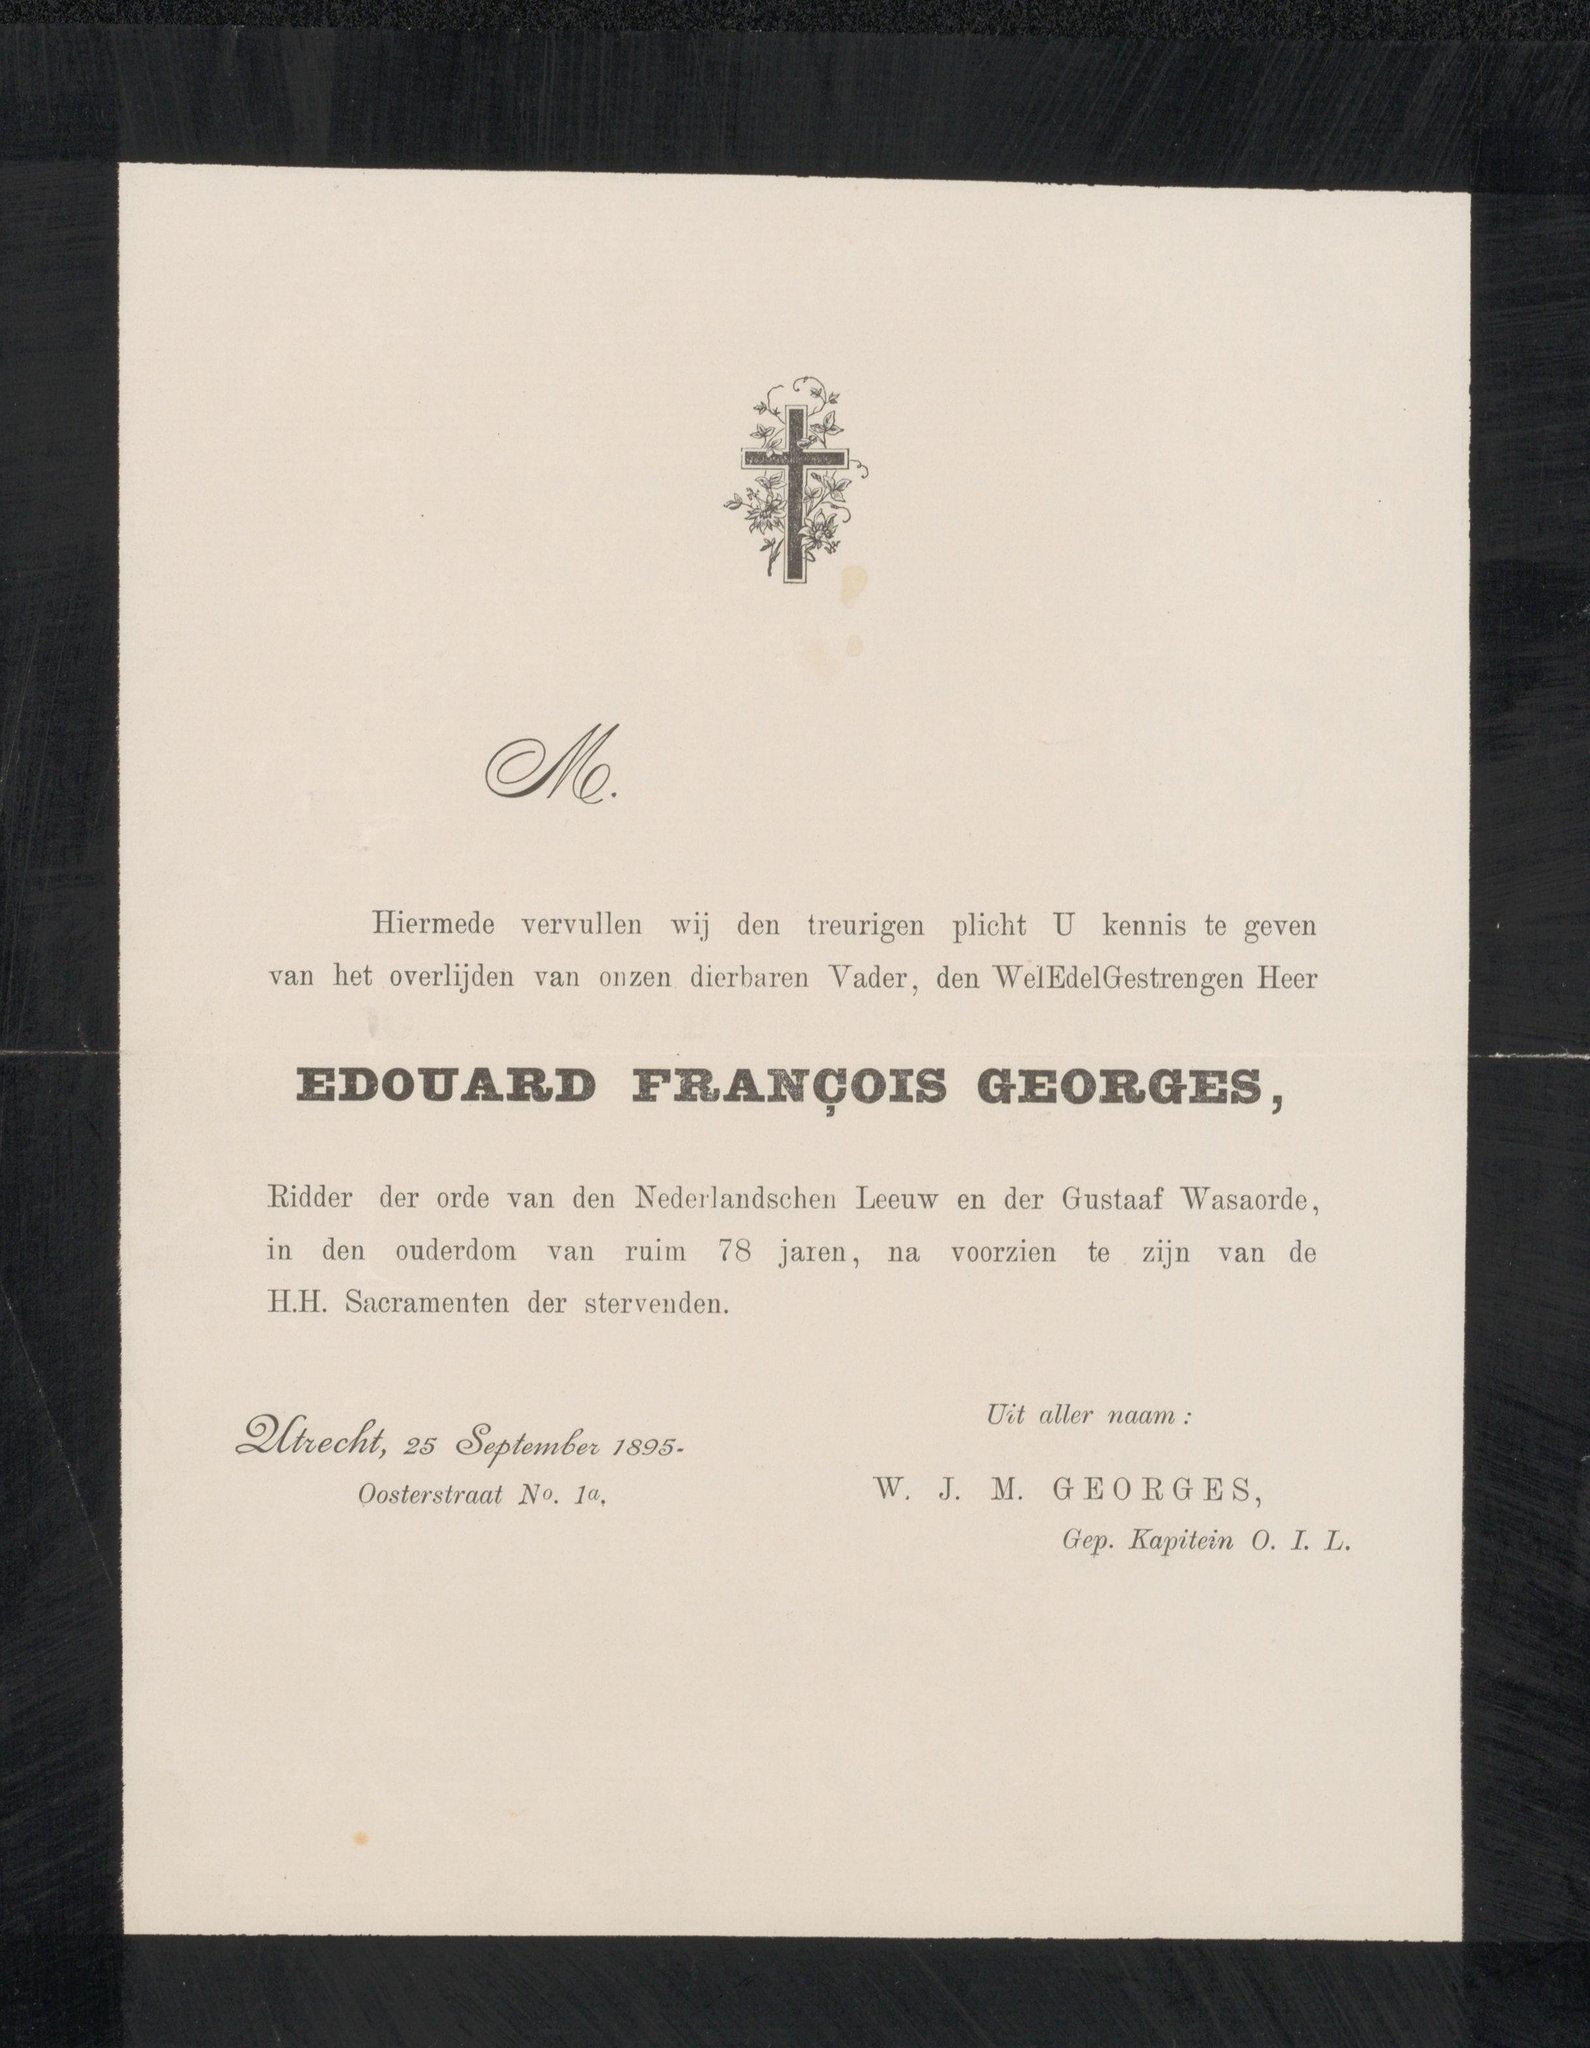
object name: overlijdensbericht, overlijdensadvertentie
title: Overlijdensbericht betreffende Eduard François Georges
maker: Anonymous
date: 1895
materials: paper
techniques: printing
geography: utrecht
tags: amsterdam, sculptor, eduard françois georges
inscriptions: watermark